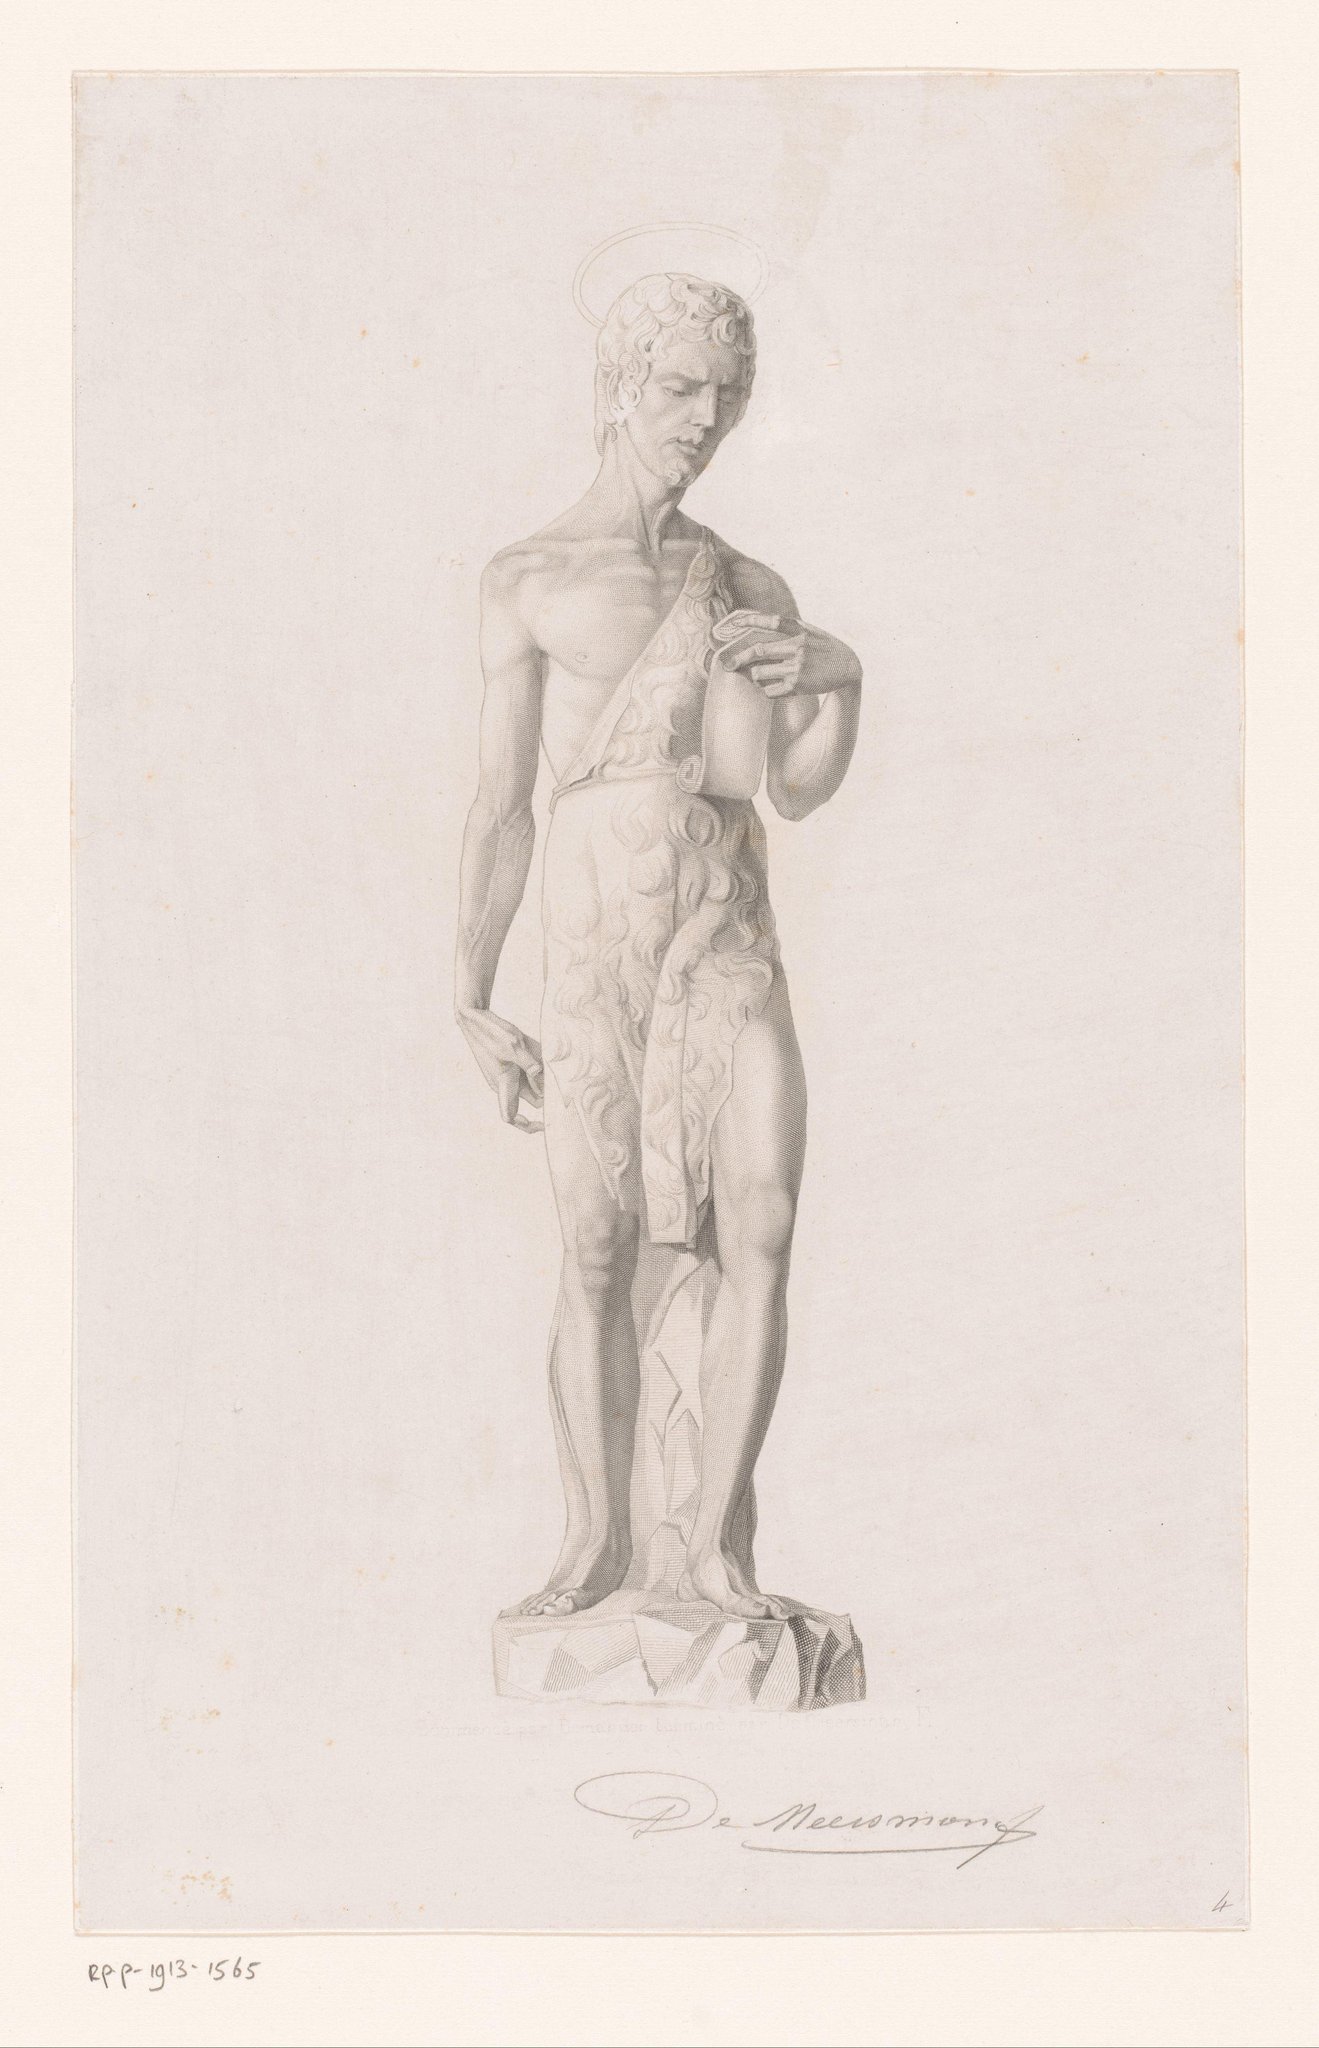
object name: print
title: Beeld van Johannes de Doper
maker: françois de meersman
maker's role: print maker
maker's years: 1830-1905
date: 1840-1905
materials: paper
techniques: etching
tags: john the baptist; possible attributes: book, reed cross, baptismal cup, honeycomb, lamb, staff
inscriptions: collector's mark: Lugt 2228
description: Voorstelling is gemaakt naar een renaissance beeld in het Bargello te Florence.